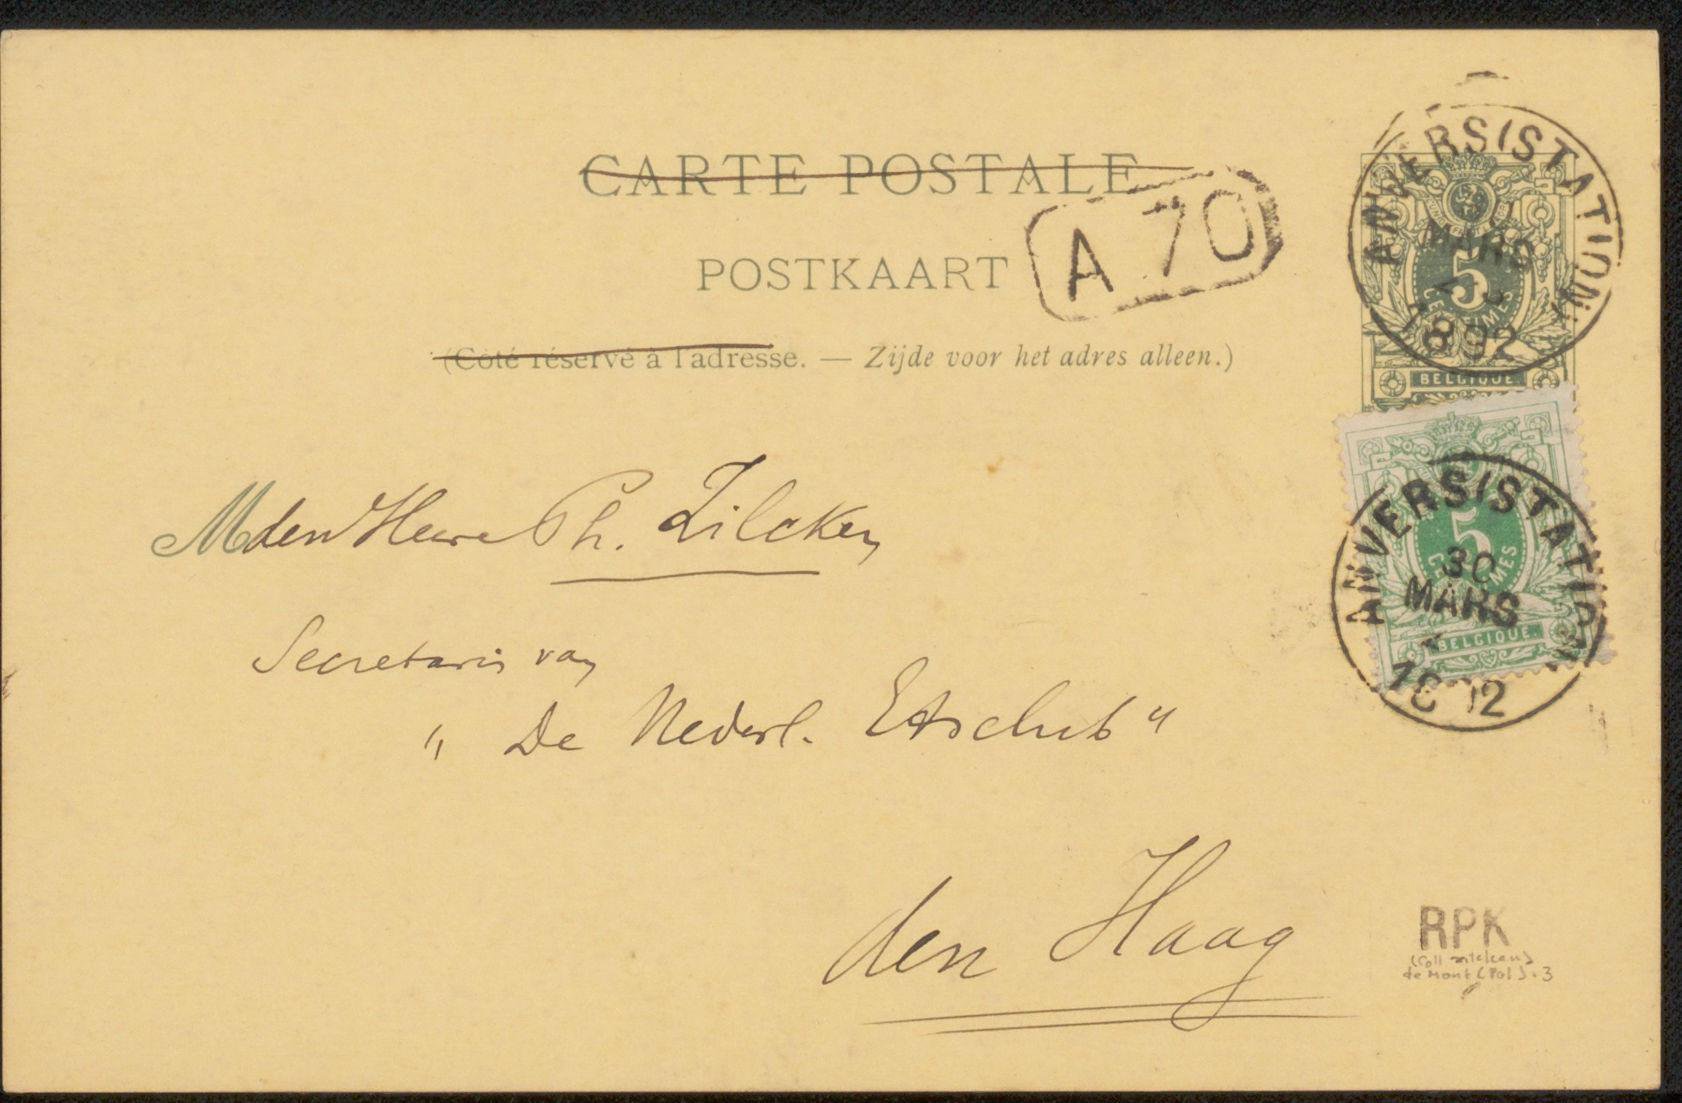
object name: postcard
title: Briefkaart aan Philip Zilcken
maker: pol de mont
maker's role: dichter, prozaschrijver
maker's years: 1857-1931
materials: cardboard, ink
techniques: pen, writing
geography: antwerp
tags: the hague, draughtsman, philip zilcken, photography, cinematography, exhibition ~ art, antwerp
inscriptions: collector's mark: ‘RPK’